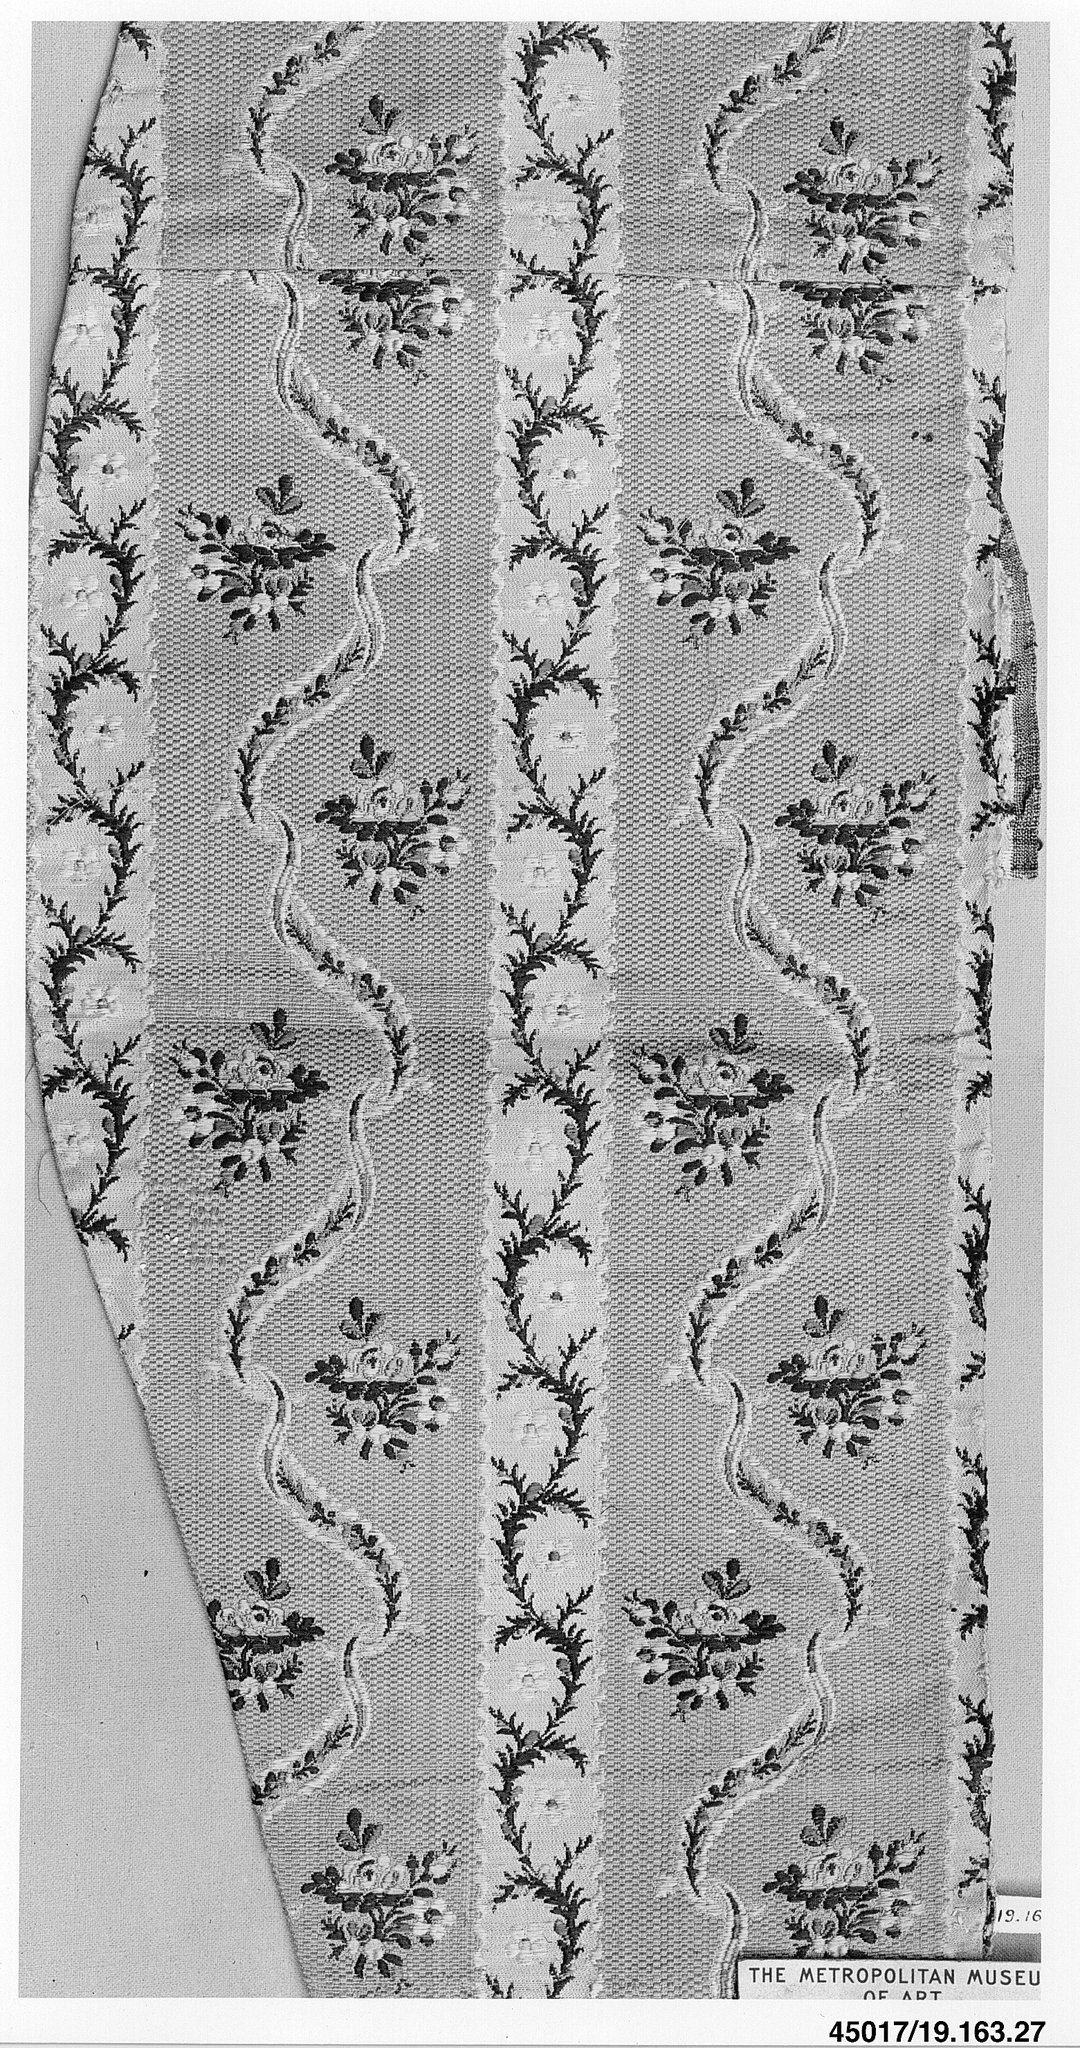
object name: fragment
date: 1767-1800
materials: silk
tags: flowers,leaves